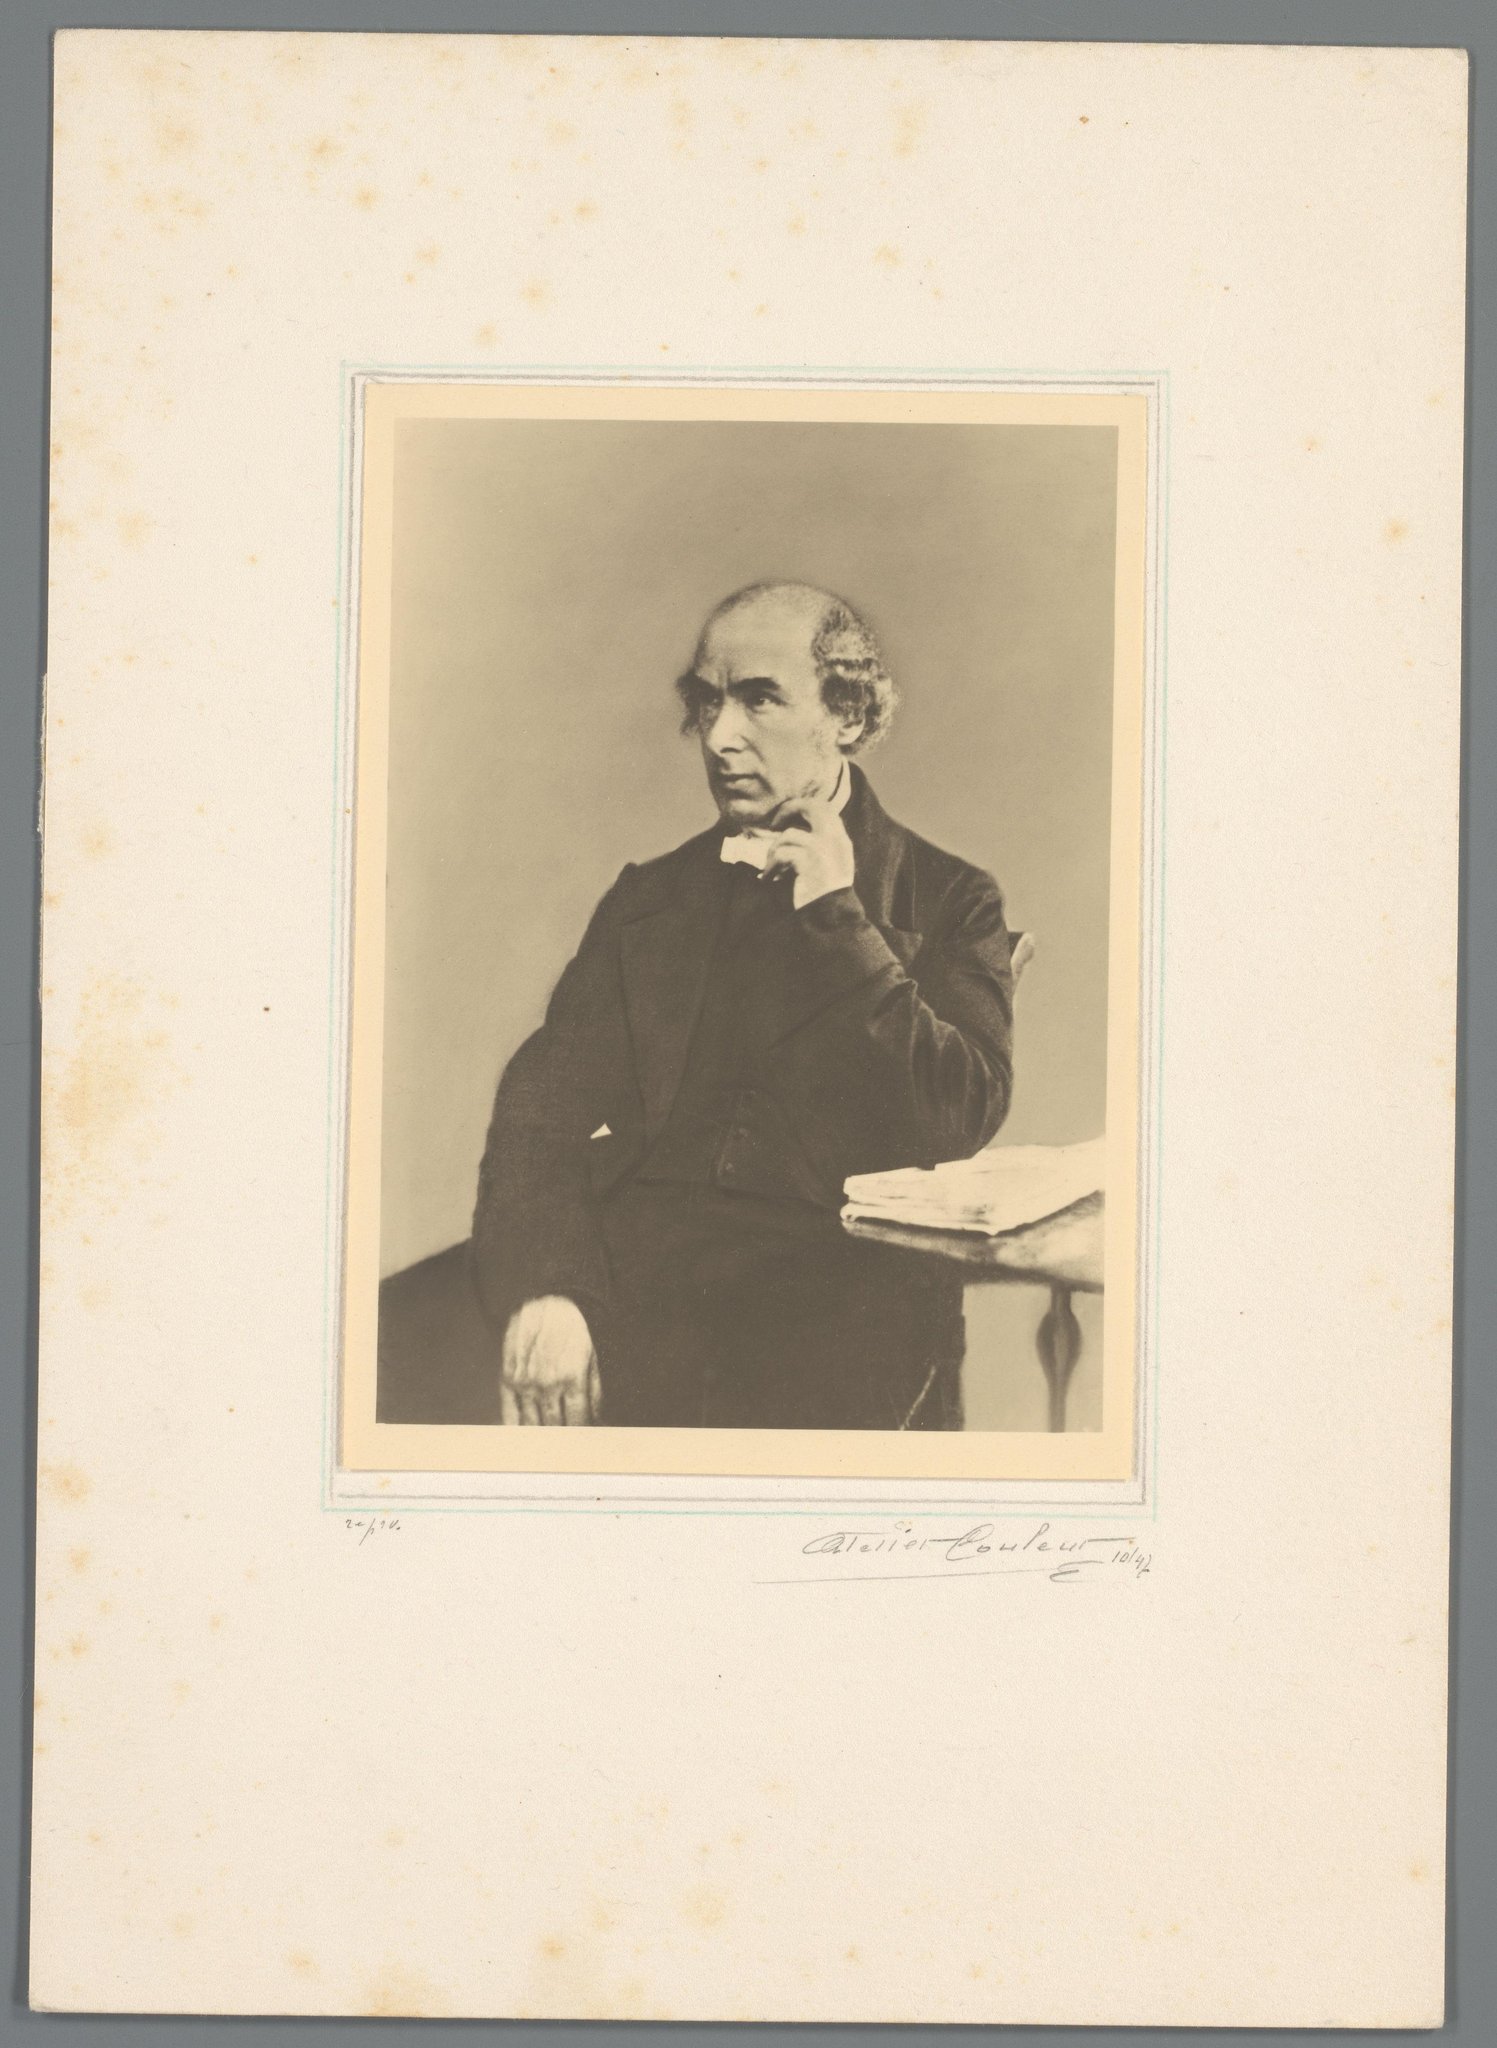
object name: carte de visite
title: Portret van een onbekende man in kostuum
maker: pieter wilhelmus roemer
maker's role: fotograaf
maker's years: 1838-1924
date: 1864-1900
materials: cardboard, photographic support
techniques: albumen print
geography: rotterdam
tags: historical persons not known by name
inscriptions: number: ‘200’